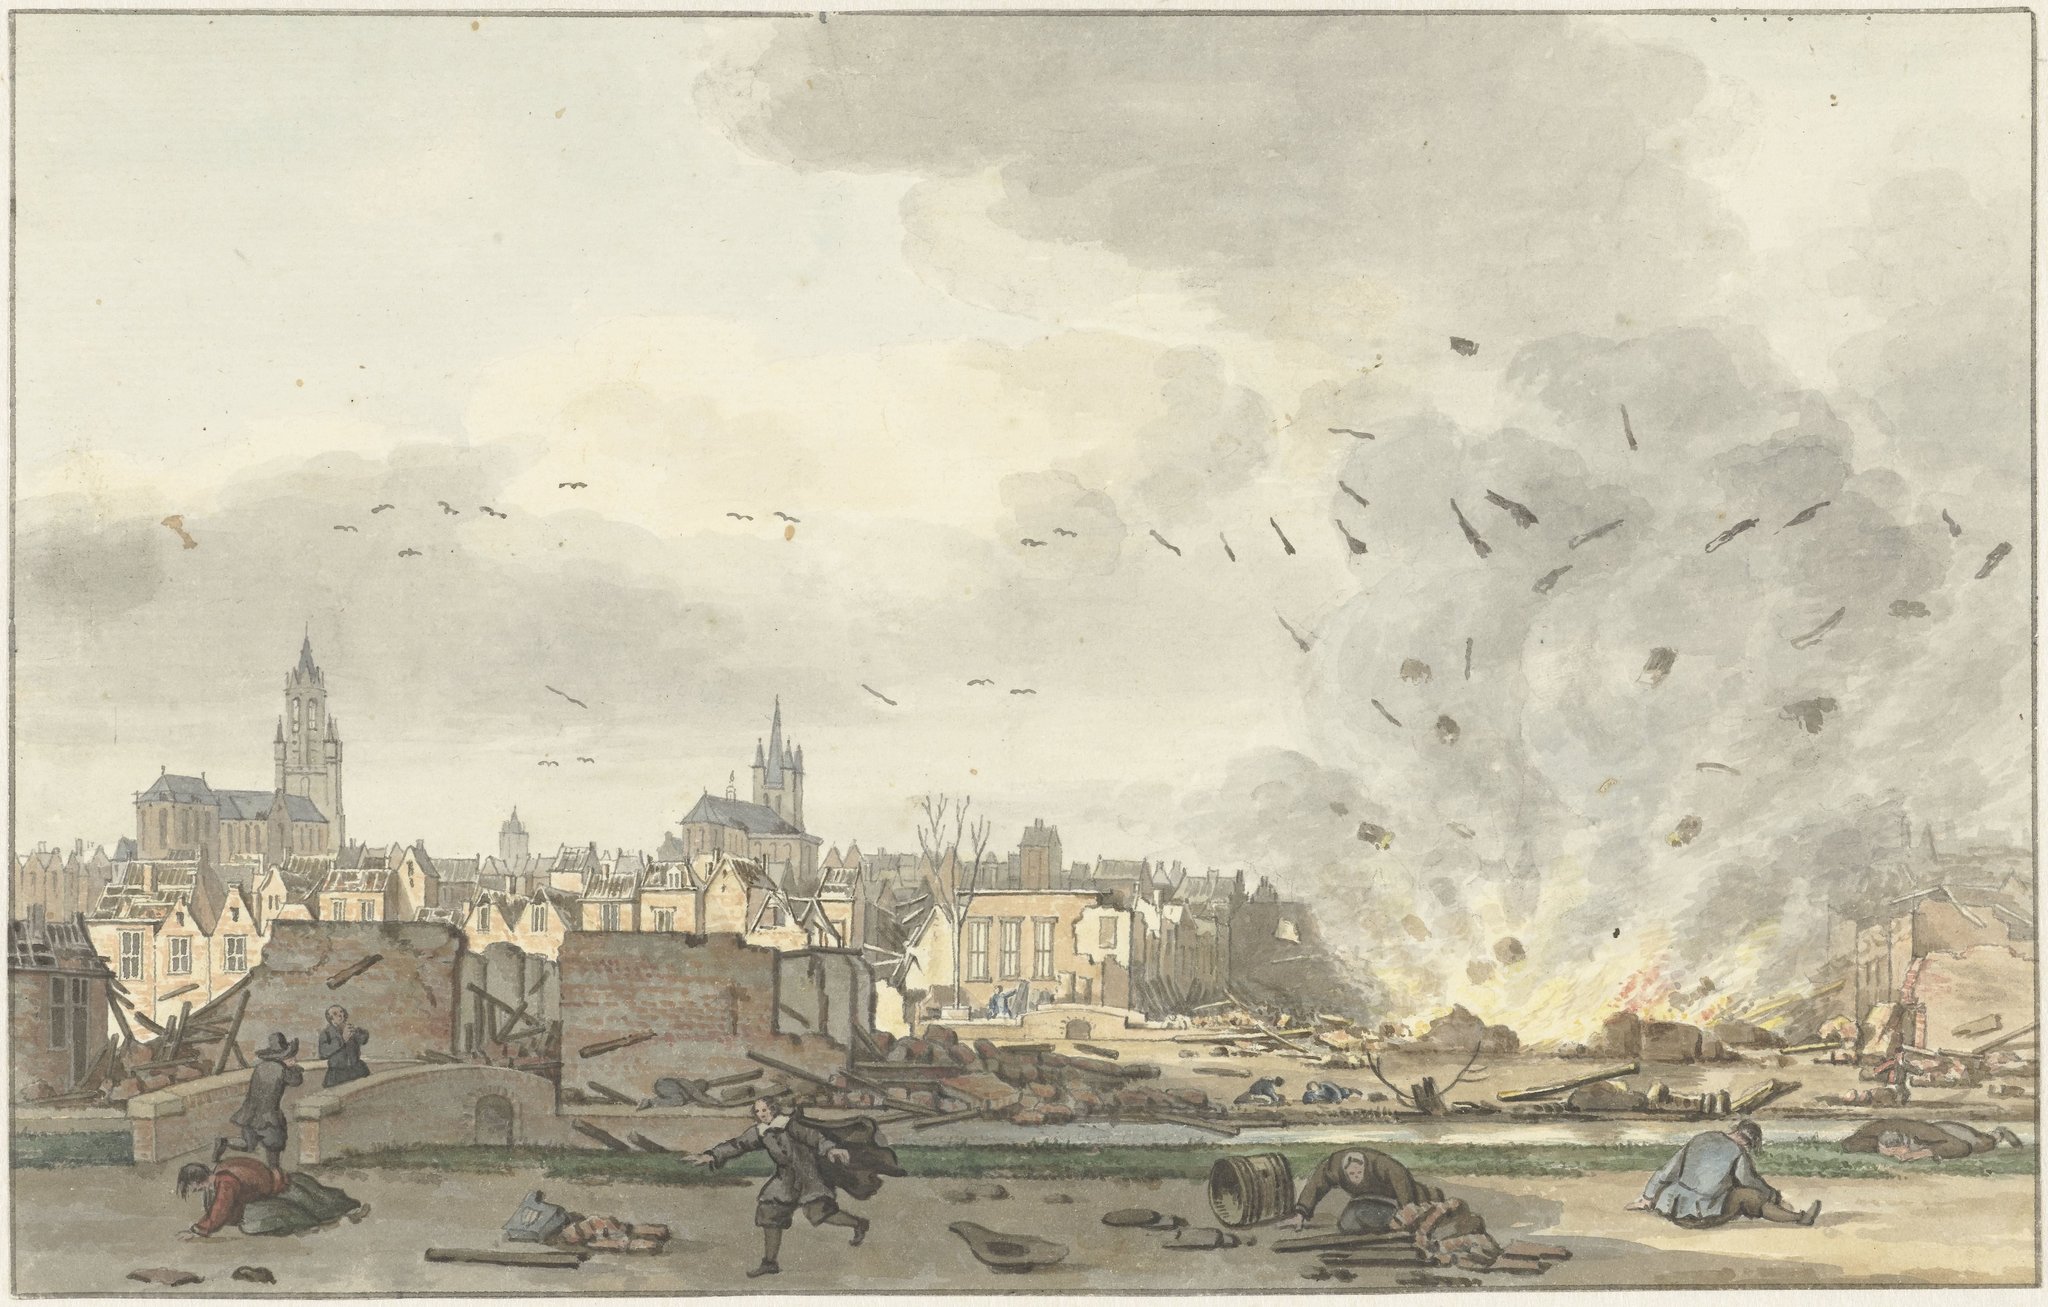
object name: drawing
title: De ontploffing van het Kruithuis in Delft, 12 oktober 1654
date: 1758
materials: ink, paper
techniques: brush, pen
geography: northern netherlands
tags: gunpowder disaster, delft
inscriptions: inscription: ‘Het springe van het Kruytmaggeseyn tot Delft den 12 Octob. 1654 / van der Poel Pinx 1654: H De Winter del: 1758’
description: Gezicht op de verwoeste straten en huizen in Delft na de ontploffing van het buskruitmagazijn op 12 oktober 1654. Op de grond zitten en liggen gewonde mensen. Links de Oude en de Nieuwe Kerk.